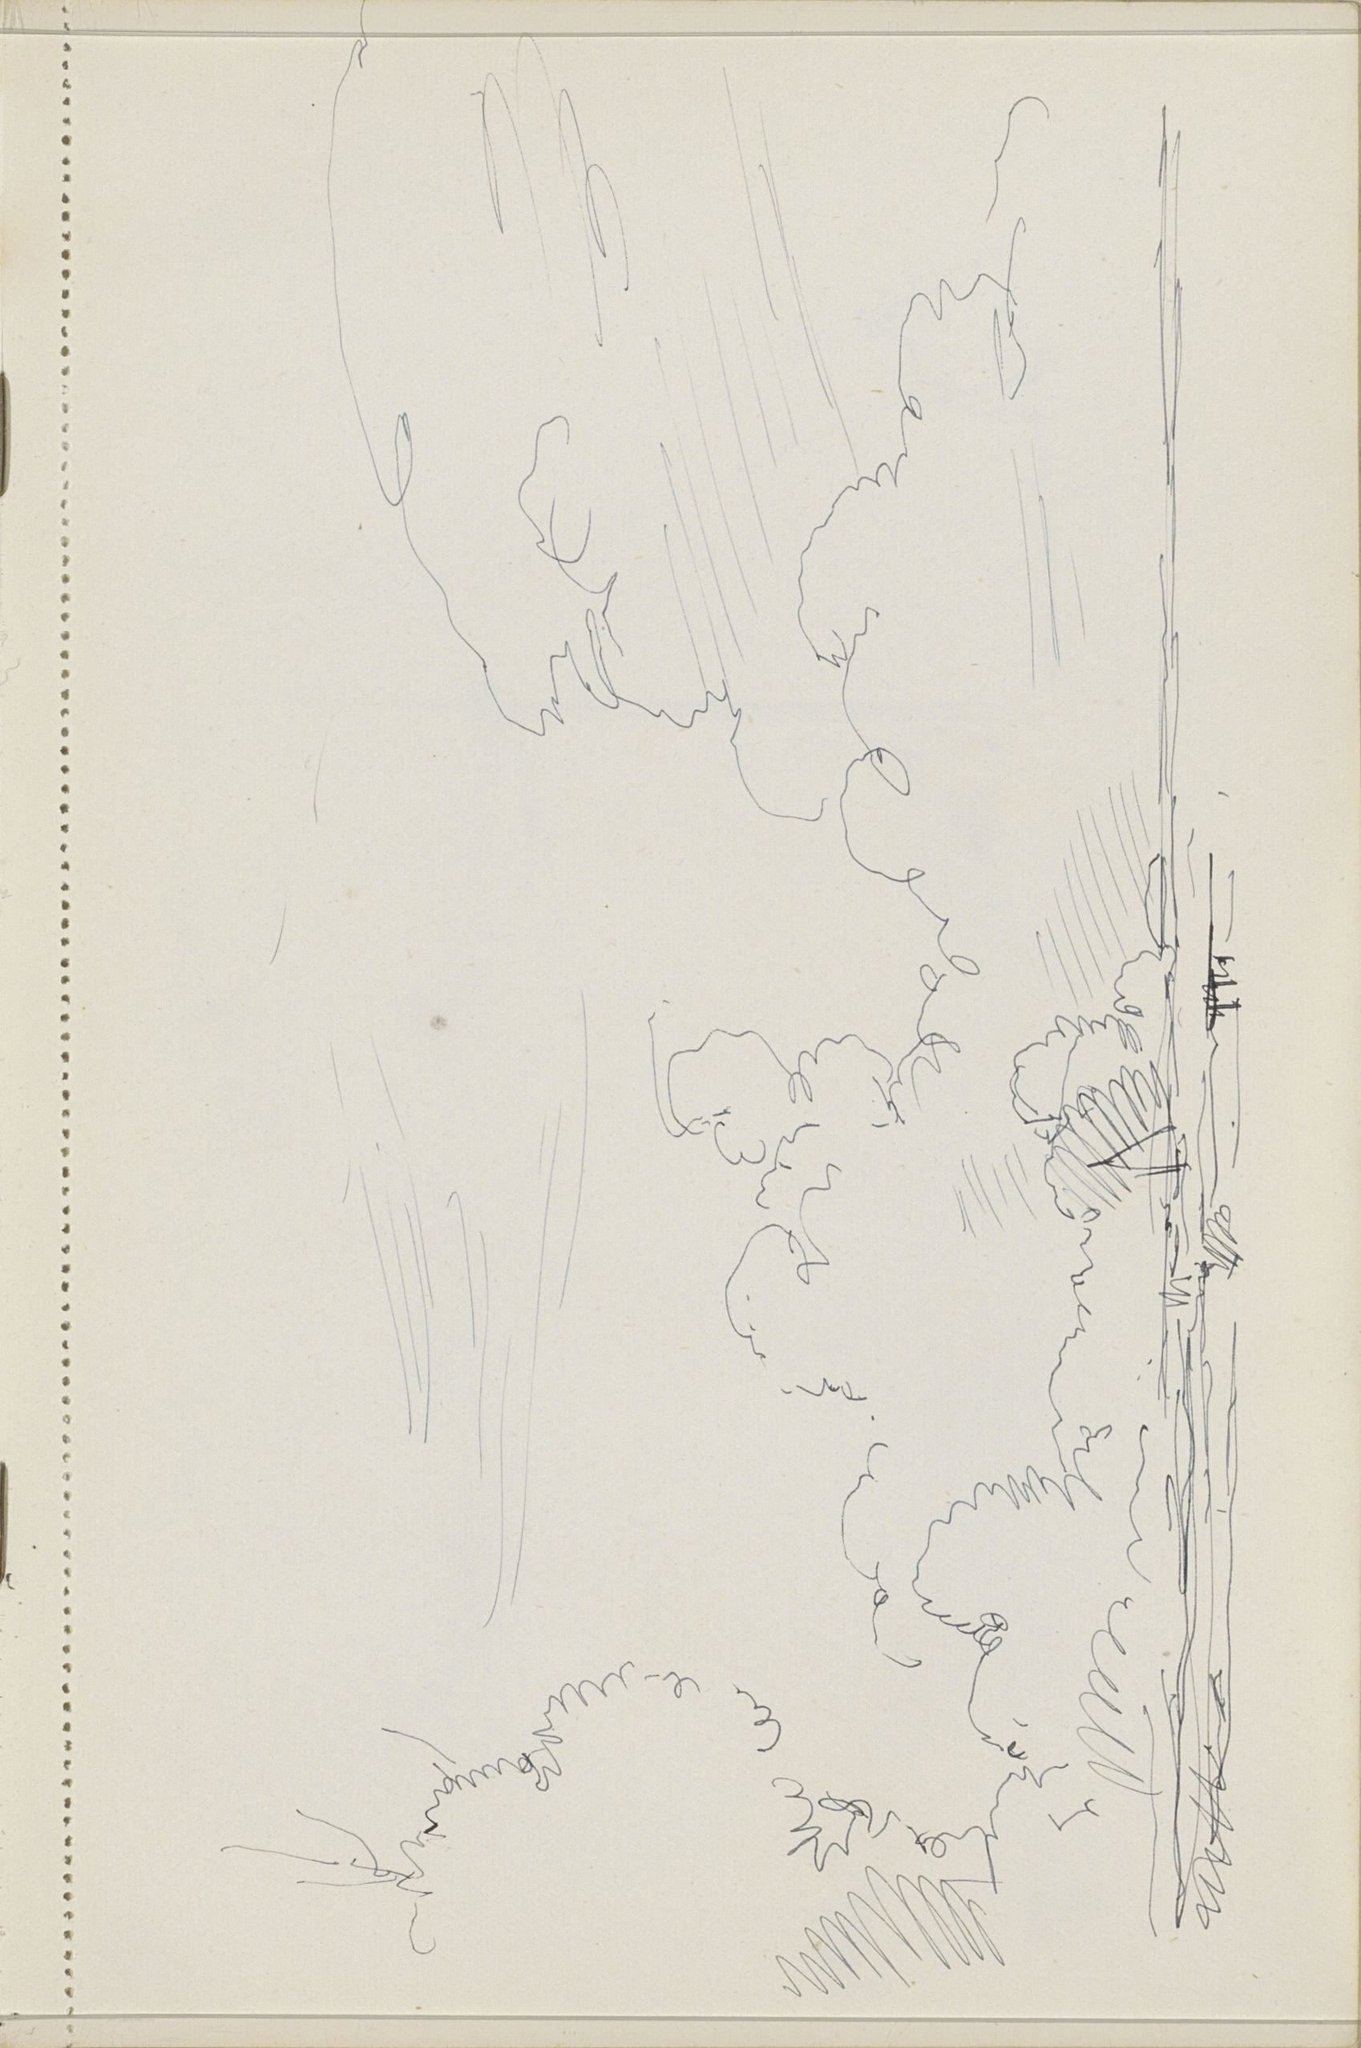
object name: sketchbook leaf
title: Zeilboot op het water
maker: cornelis vreedenburgh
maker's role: draughtsman, print maker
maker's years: 1880-1946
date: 1890-1946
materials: ink, paper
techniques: pen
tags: sailing-ship, sailing-boat, landscapes with waters, waterscapes, seascapes (in the temperate zone)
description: Blad 7 recto uit een schetsboek met uit 75 bladen.